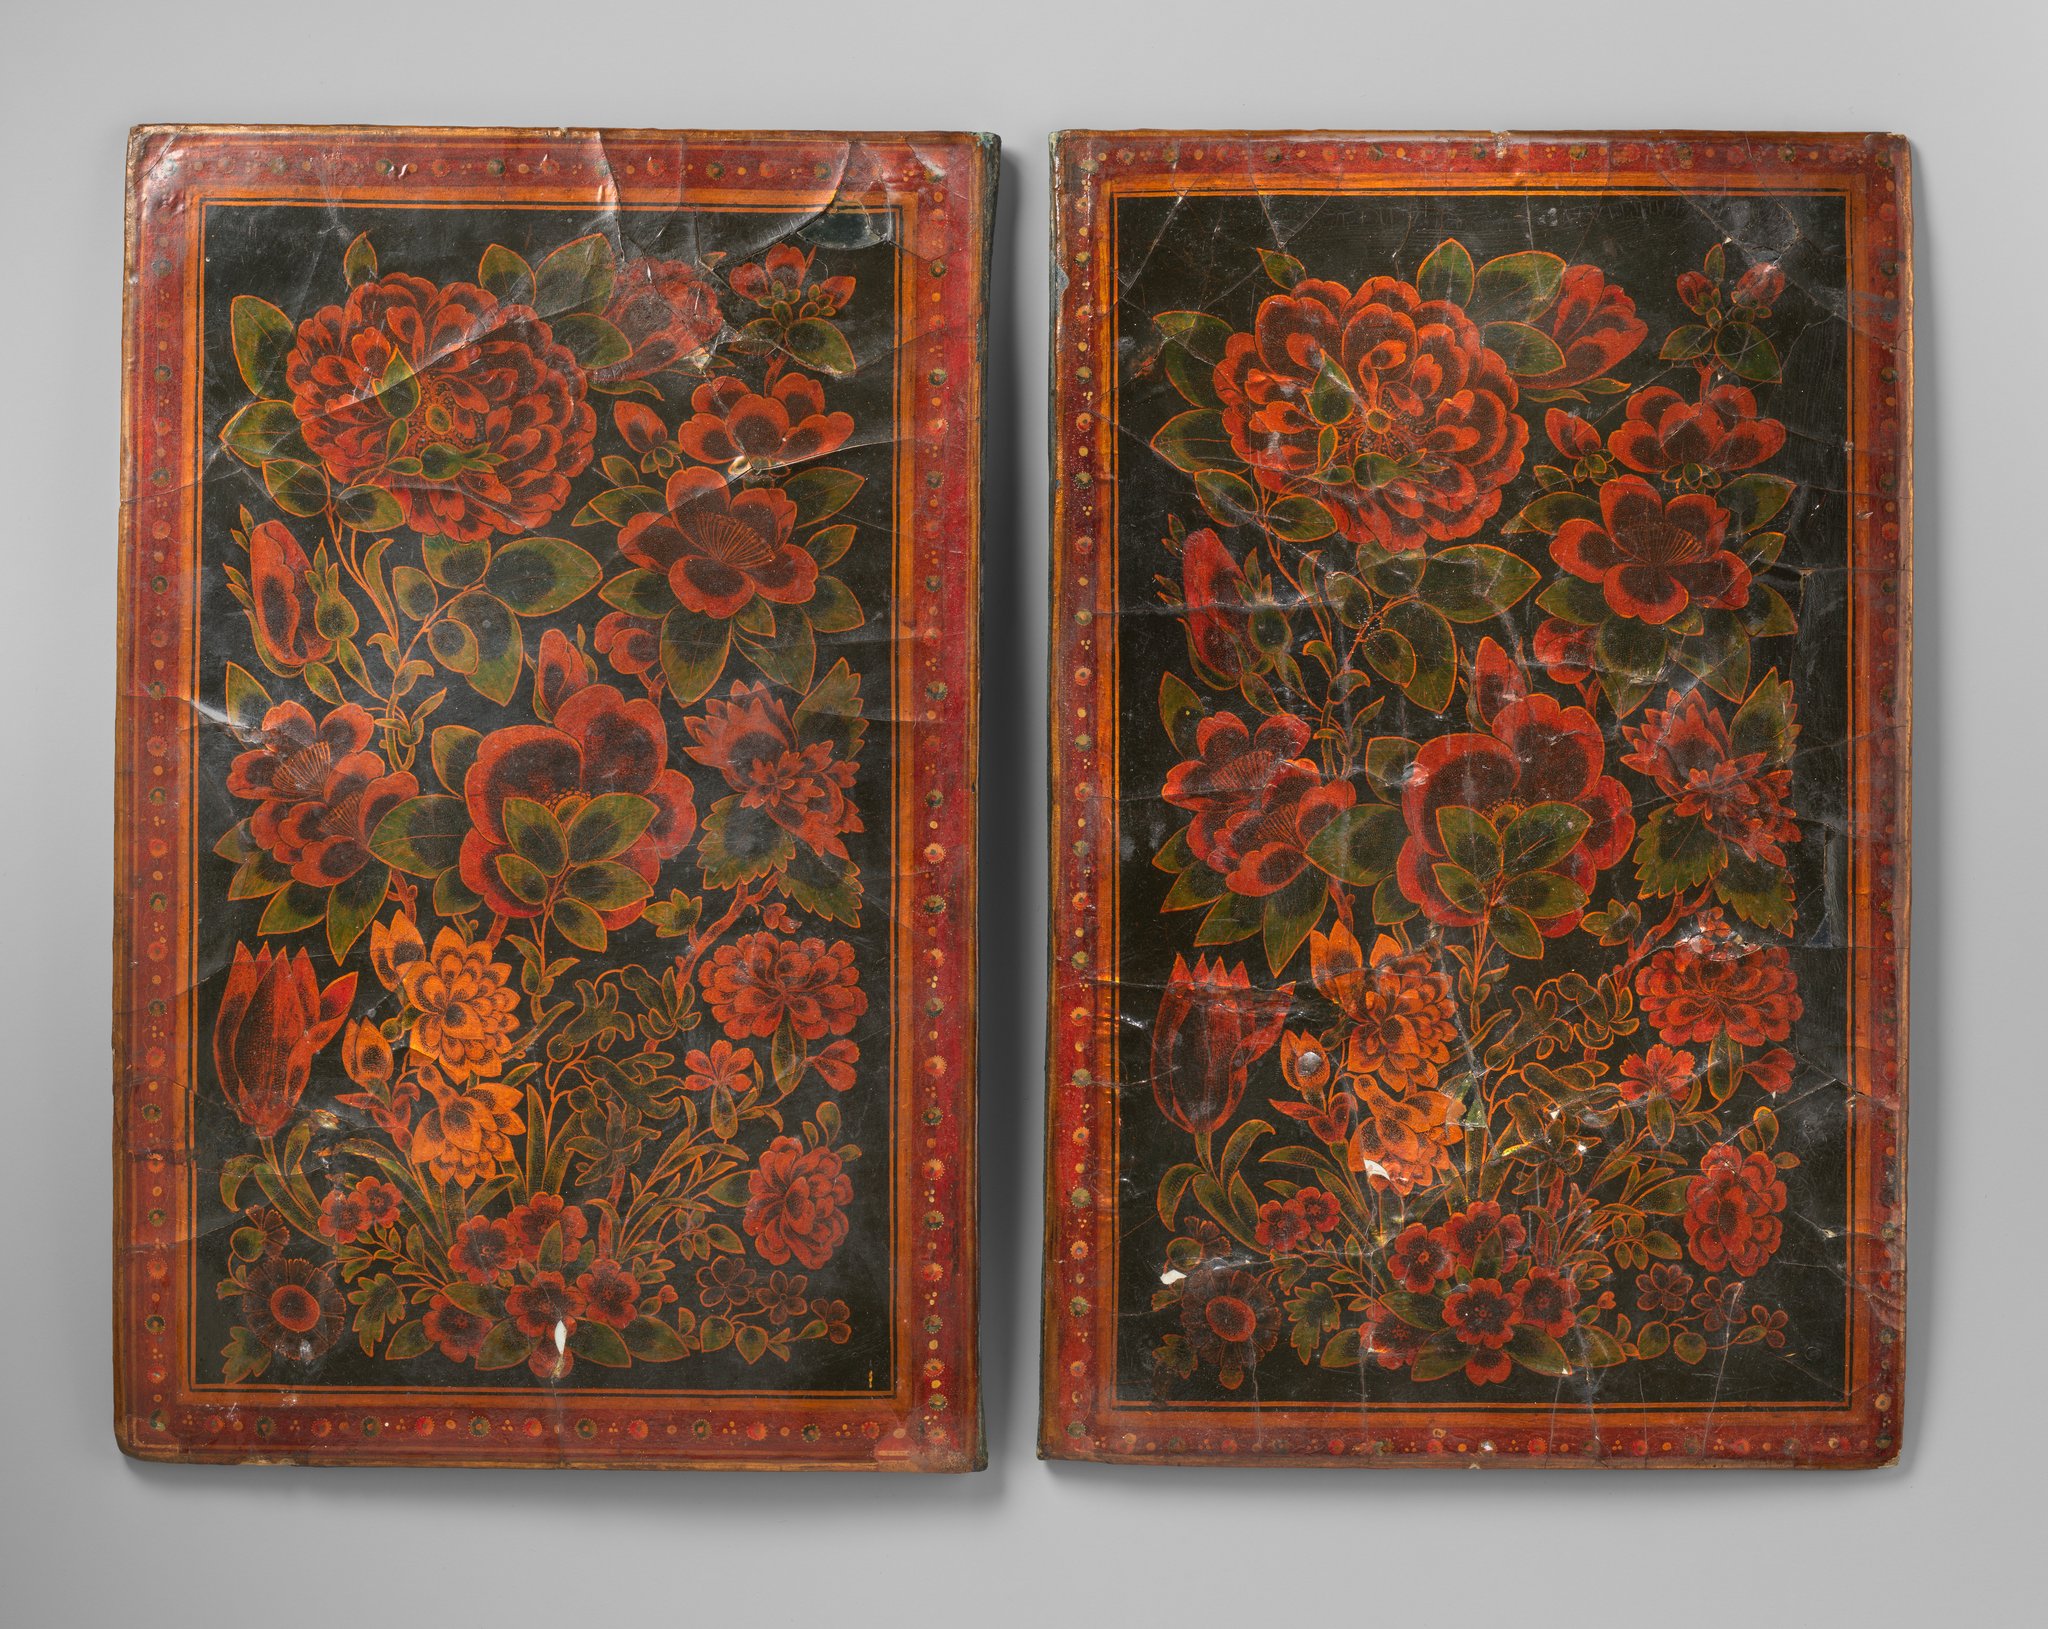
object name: bookbinding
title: Bookbinding (Jild-i kitab)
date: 1701-1900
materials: board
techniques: lacquer, painting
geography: iran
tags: flowers